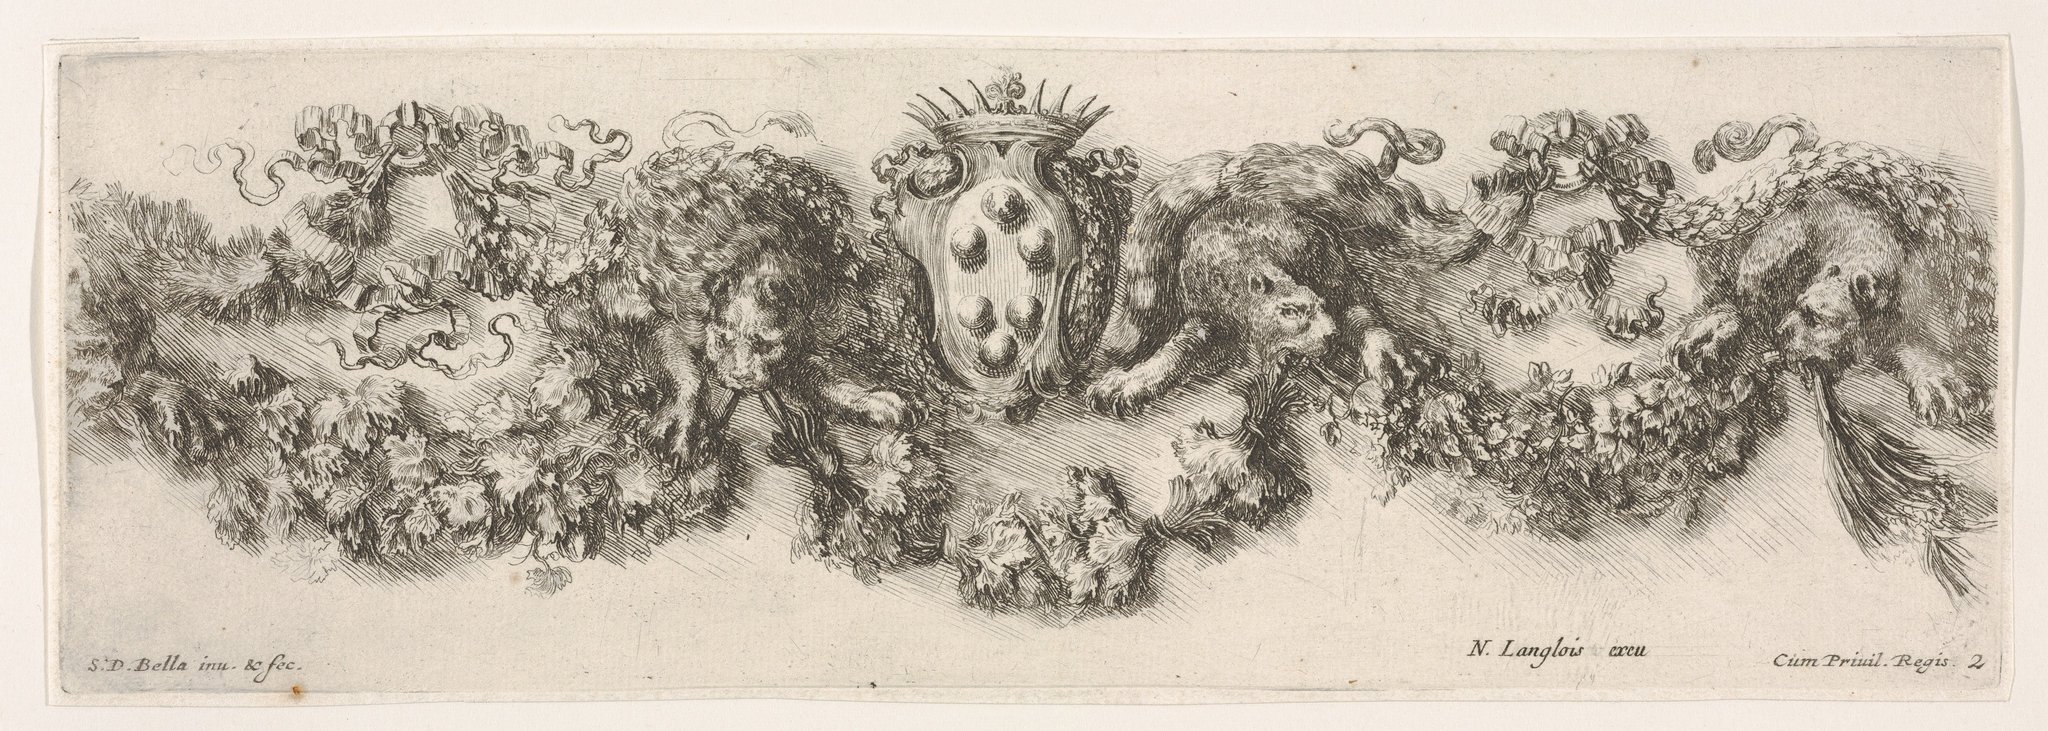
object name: print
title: Design for a Frieze with Felines holding up a Garland and the Medici Coat of Arms in the Center, plate 2 from "Decorative friezes and foliage" (Ornamenti di fregi e fogliami)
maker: stefano della bella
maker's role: artist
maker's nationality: italian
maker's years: 1610-1664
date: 1645-1650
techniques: etching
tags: animals,garlands,coat of arms